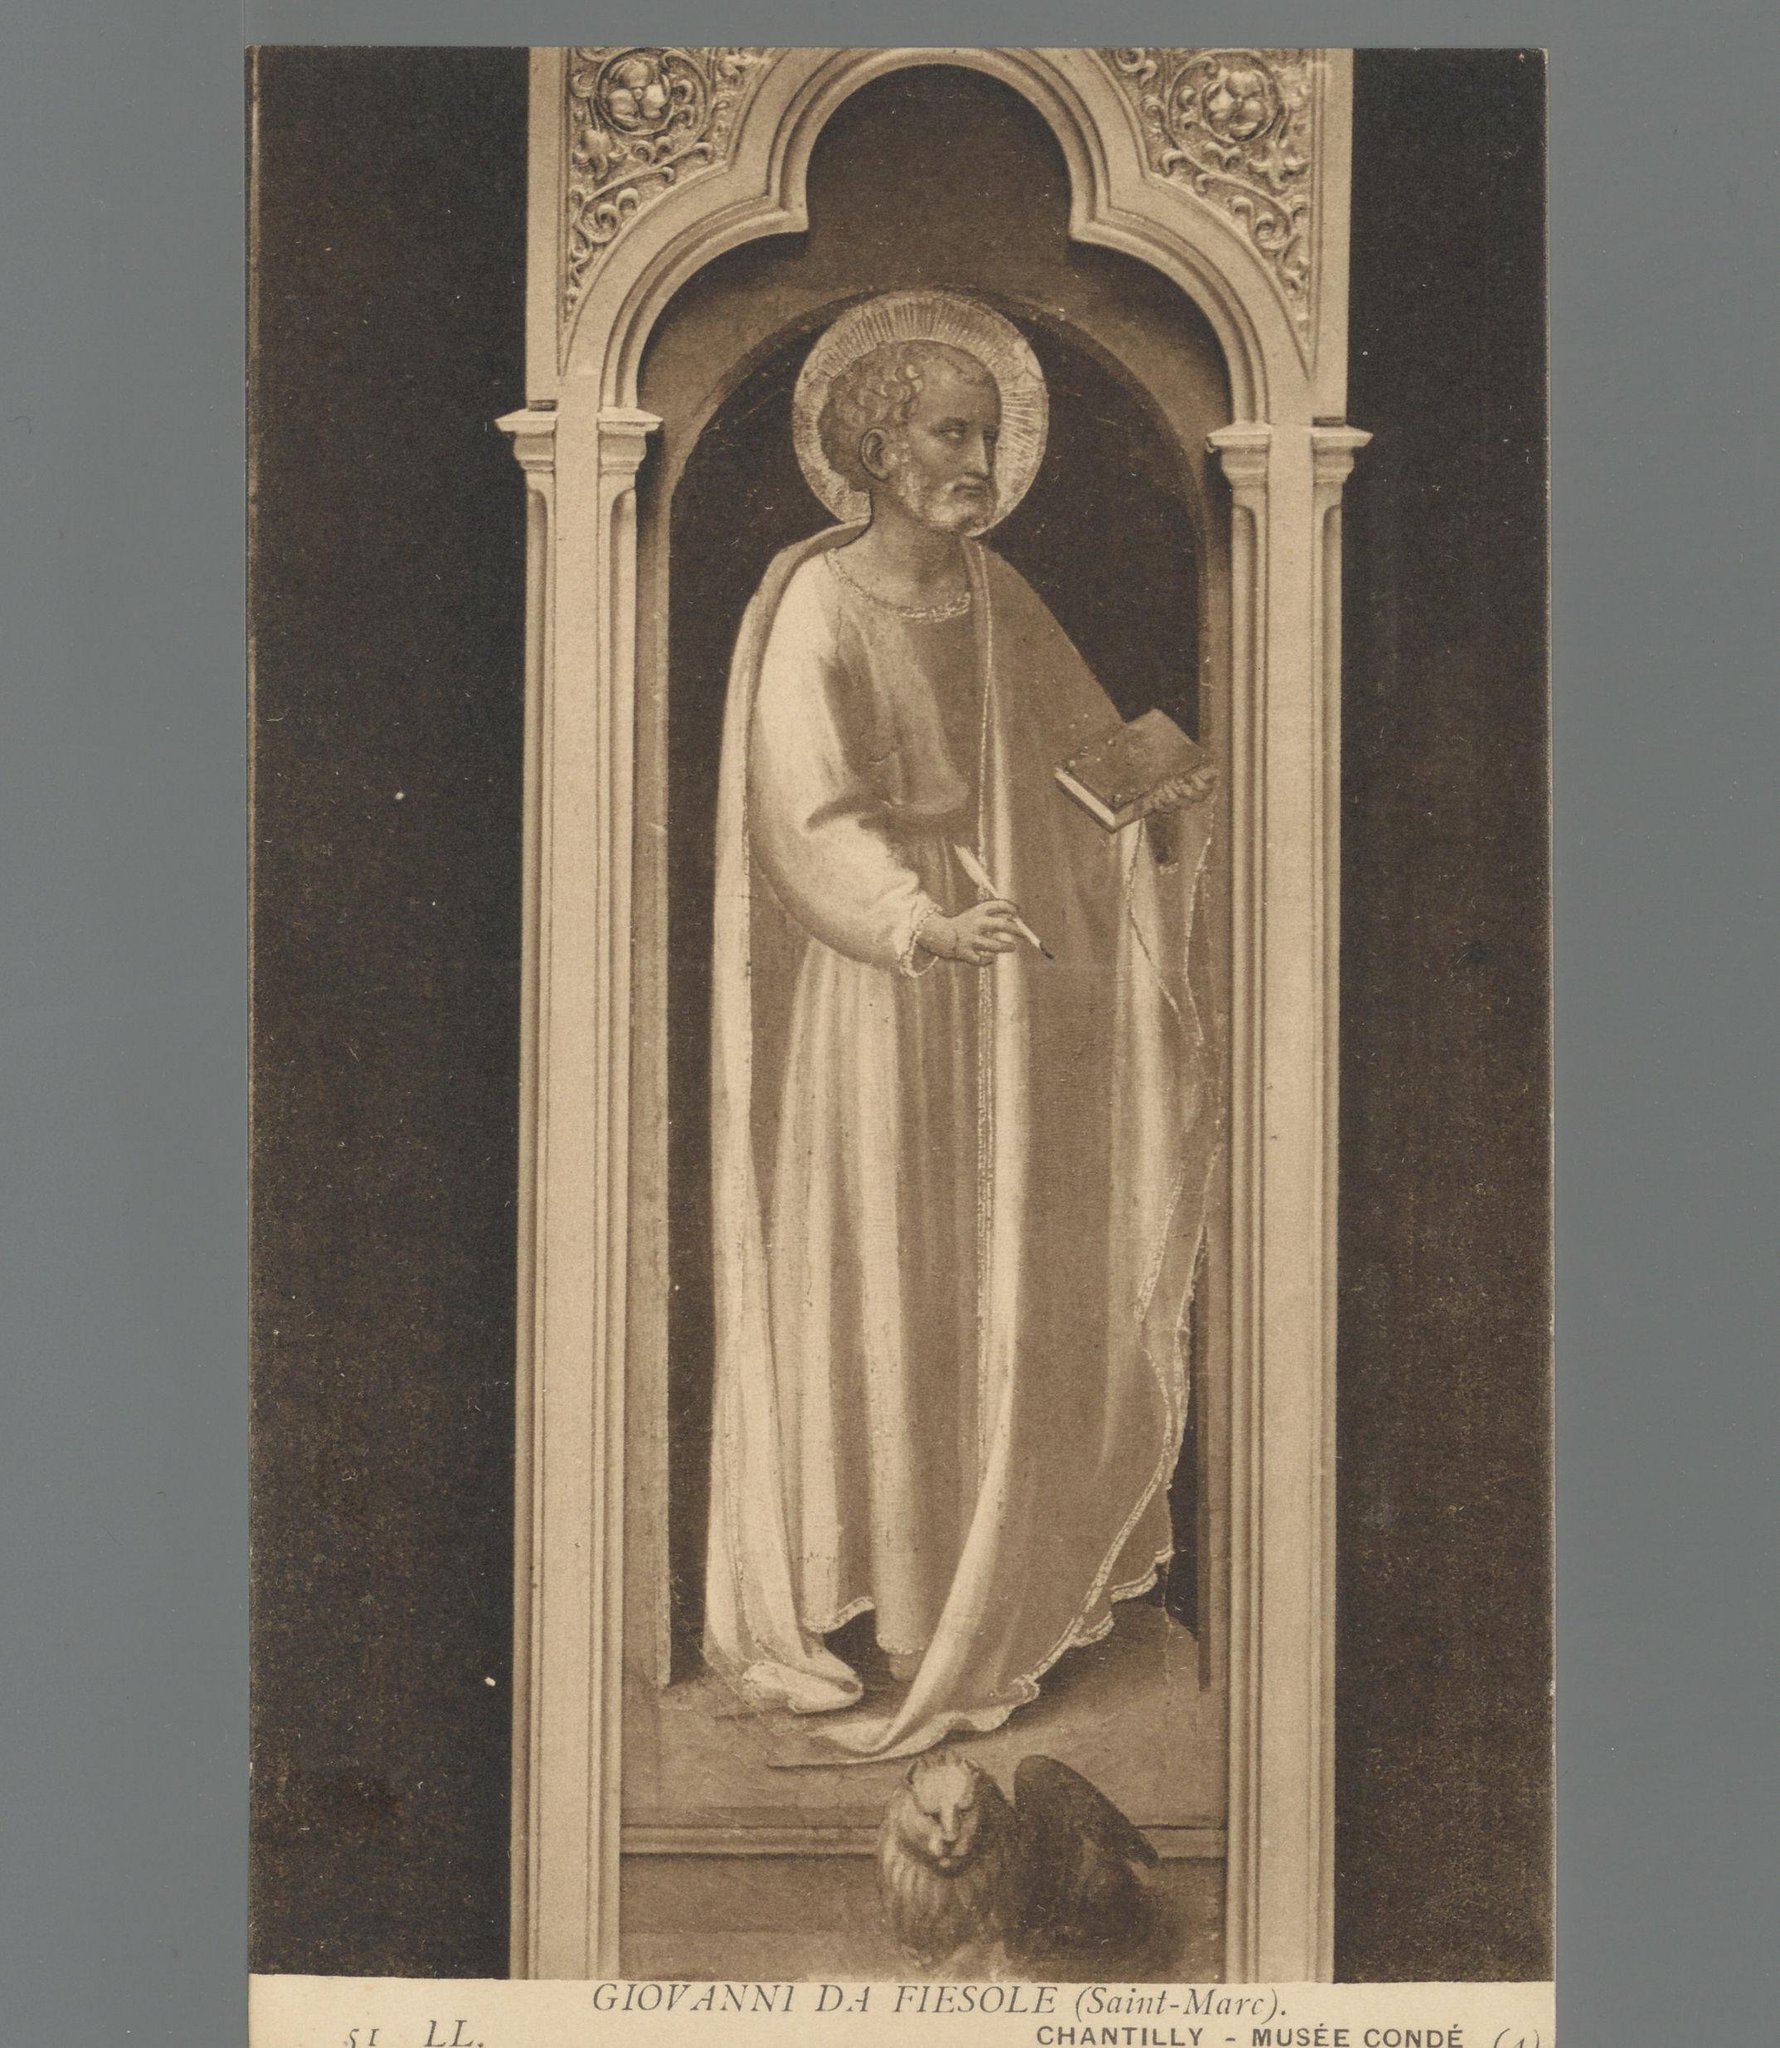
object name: photomechanical print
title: Giovanni da Fiesole (Saint-Marc). Chantilly - Musée Condé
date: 1903-1932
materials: cardboard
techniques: photograph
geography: paris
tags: statues, paintings, etc. ~ objects of worship in roman religion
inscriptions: collector's mark: ‘AFE v S’